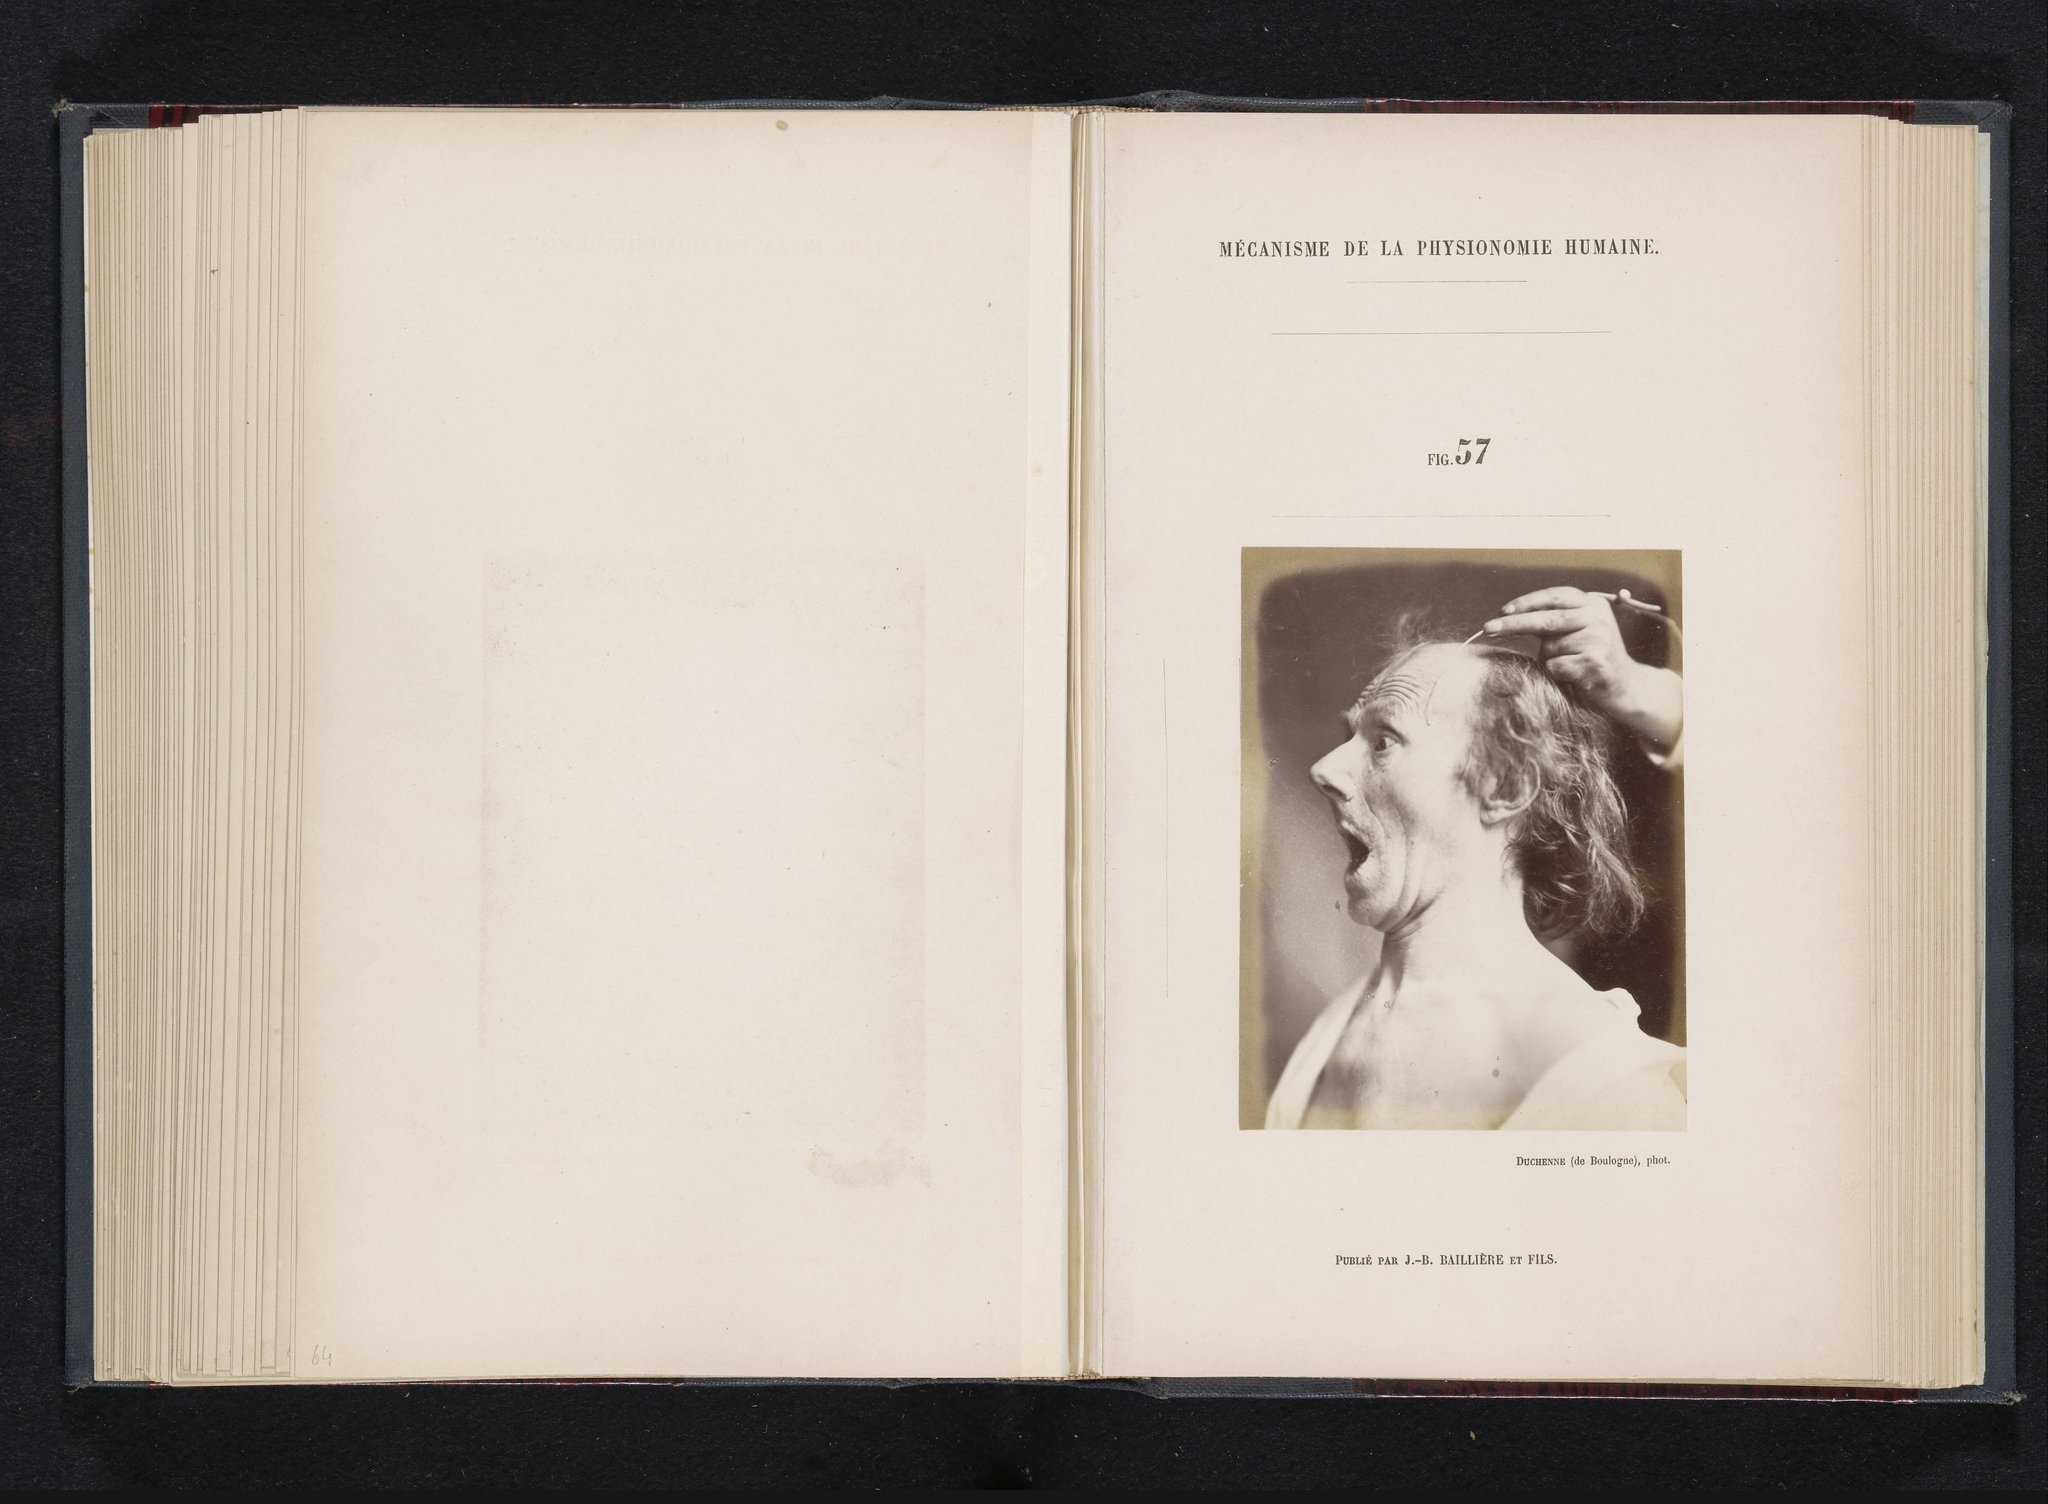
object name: photograph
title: Portret van een proefpersoon tijdens elektrostimulatie: 'un vieillard'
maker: guillaume benjamin amand duchenne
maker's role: fotograaf, medicus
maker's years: 1806-1875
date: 1860-1862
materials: paper, photographic support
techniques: albumen print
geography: france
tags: face, physiology and anatomy ~ nervous system, neurology, physiology and anatomy, old man, morphology of facial expression, physiognomy, experiment, test ~ science and technology, france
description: Ongenummerde pagina met foto 57 uit Mécanisme de la physionomie humaine ou analyse électro-physiologique de l'expression des passions (Atlas).